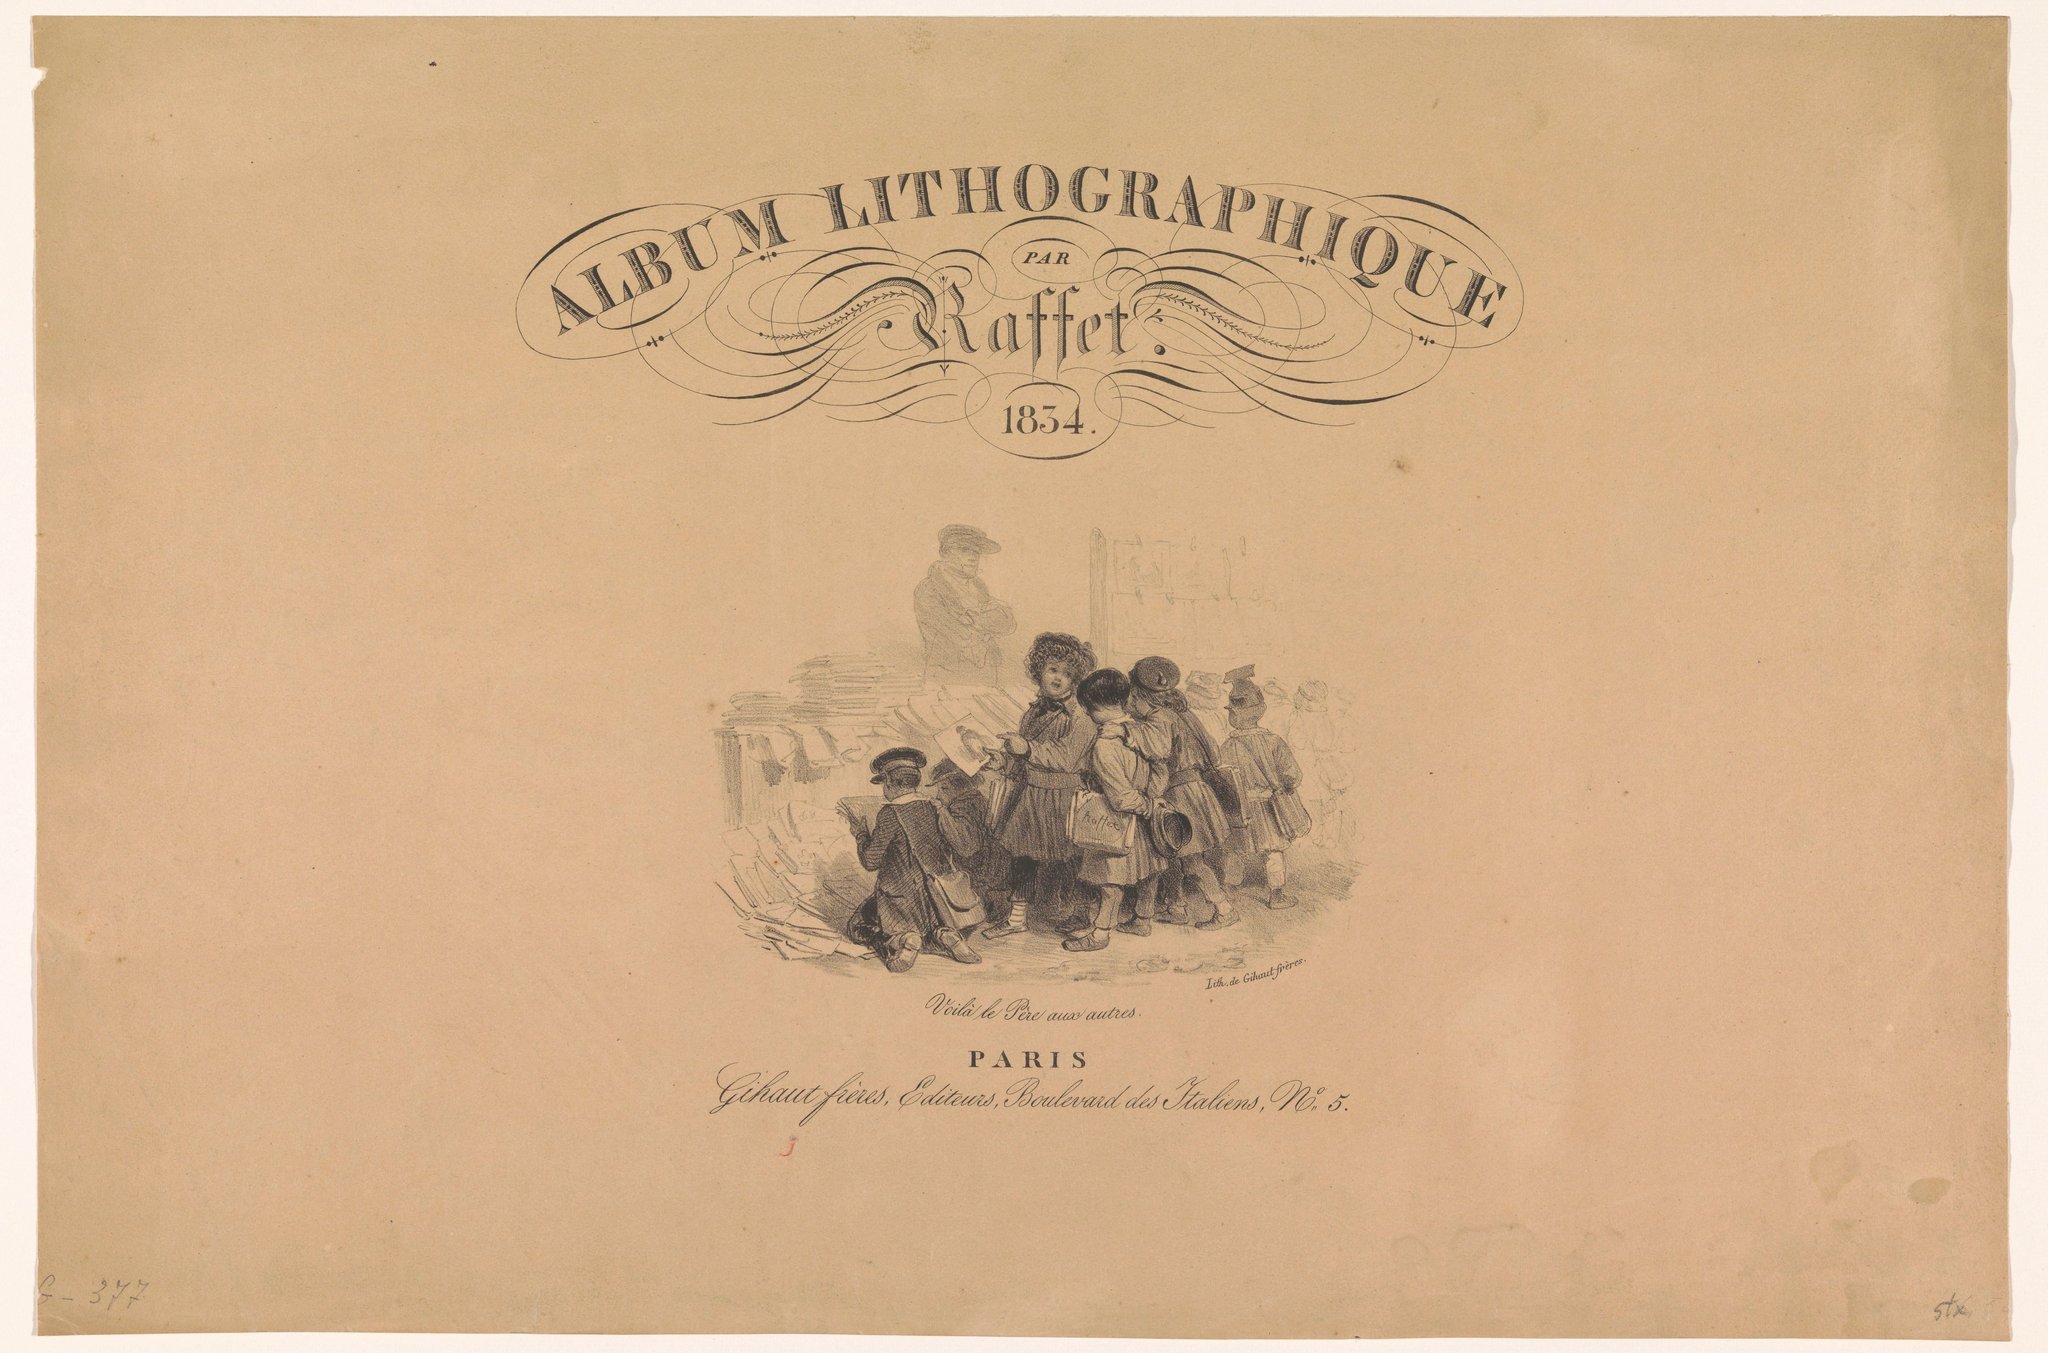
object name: titelprent, frontispice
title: Kinderen voor de kraam van een prenthandelaar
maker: denis auguste marie raffet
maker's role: draughtsman, print maker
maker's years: 1804-1860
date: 1834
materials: paper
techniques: lithograph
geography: paris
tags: art dealer (+ graphic arts)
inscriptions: collector's mark: Lugt 4780, collector's mark: Lugt 4779, collector's mark: Lugt 2228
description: Titelprent van het 'Album lithographique 1834', bestaande uit een titelprent en twaalf prenten.